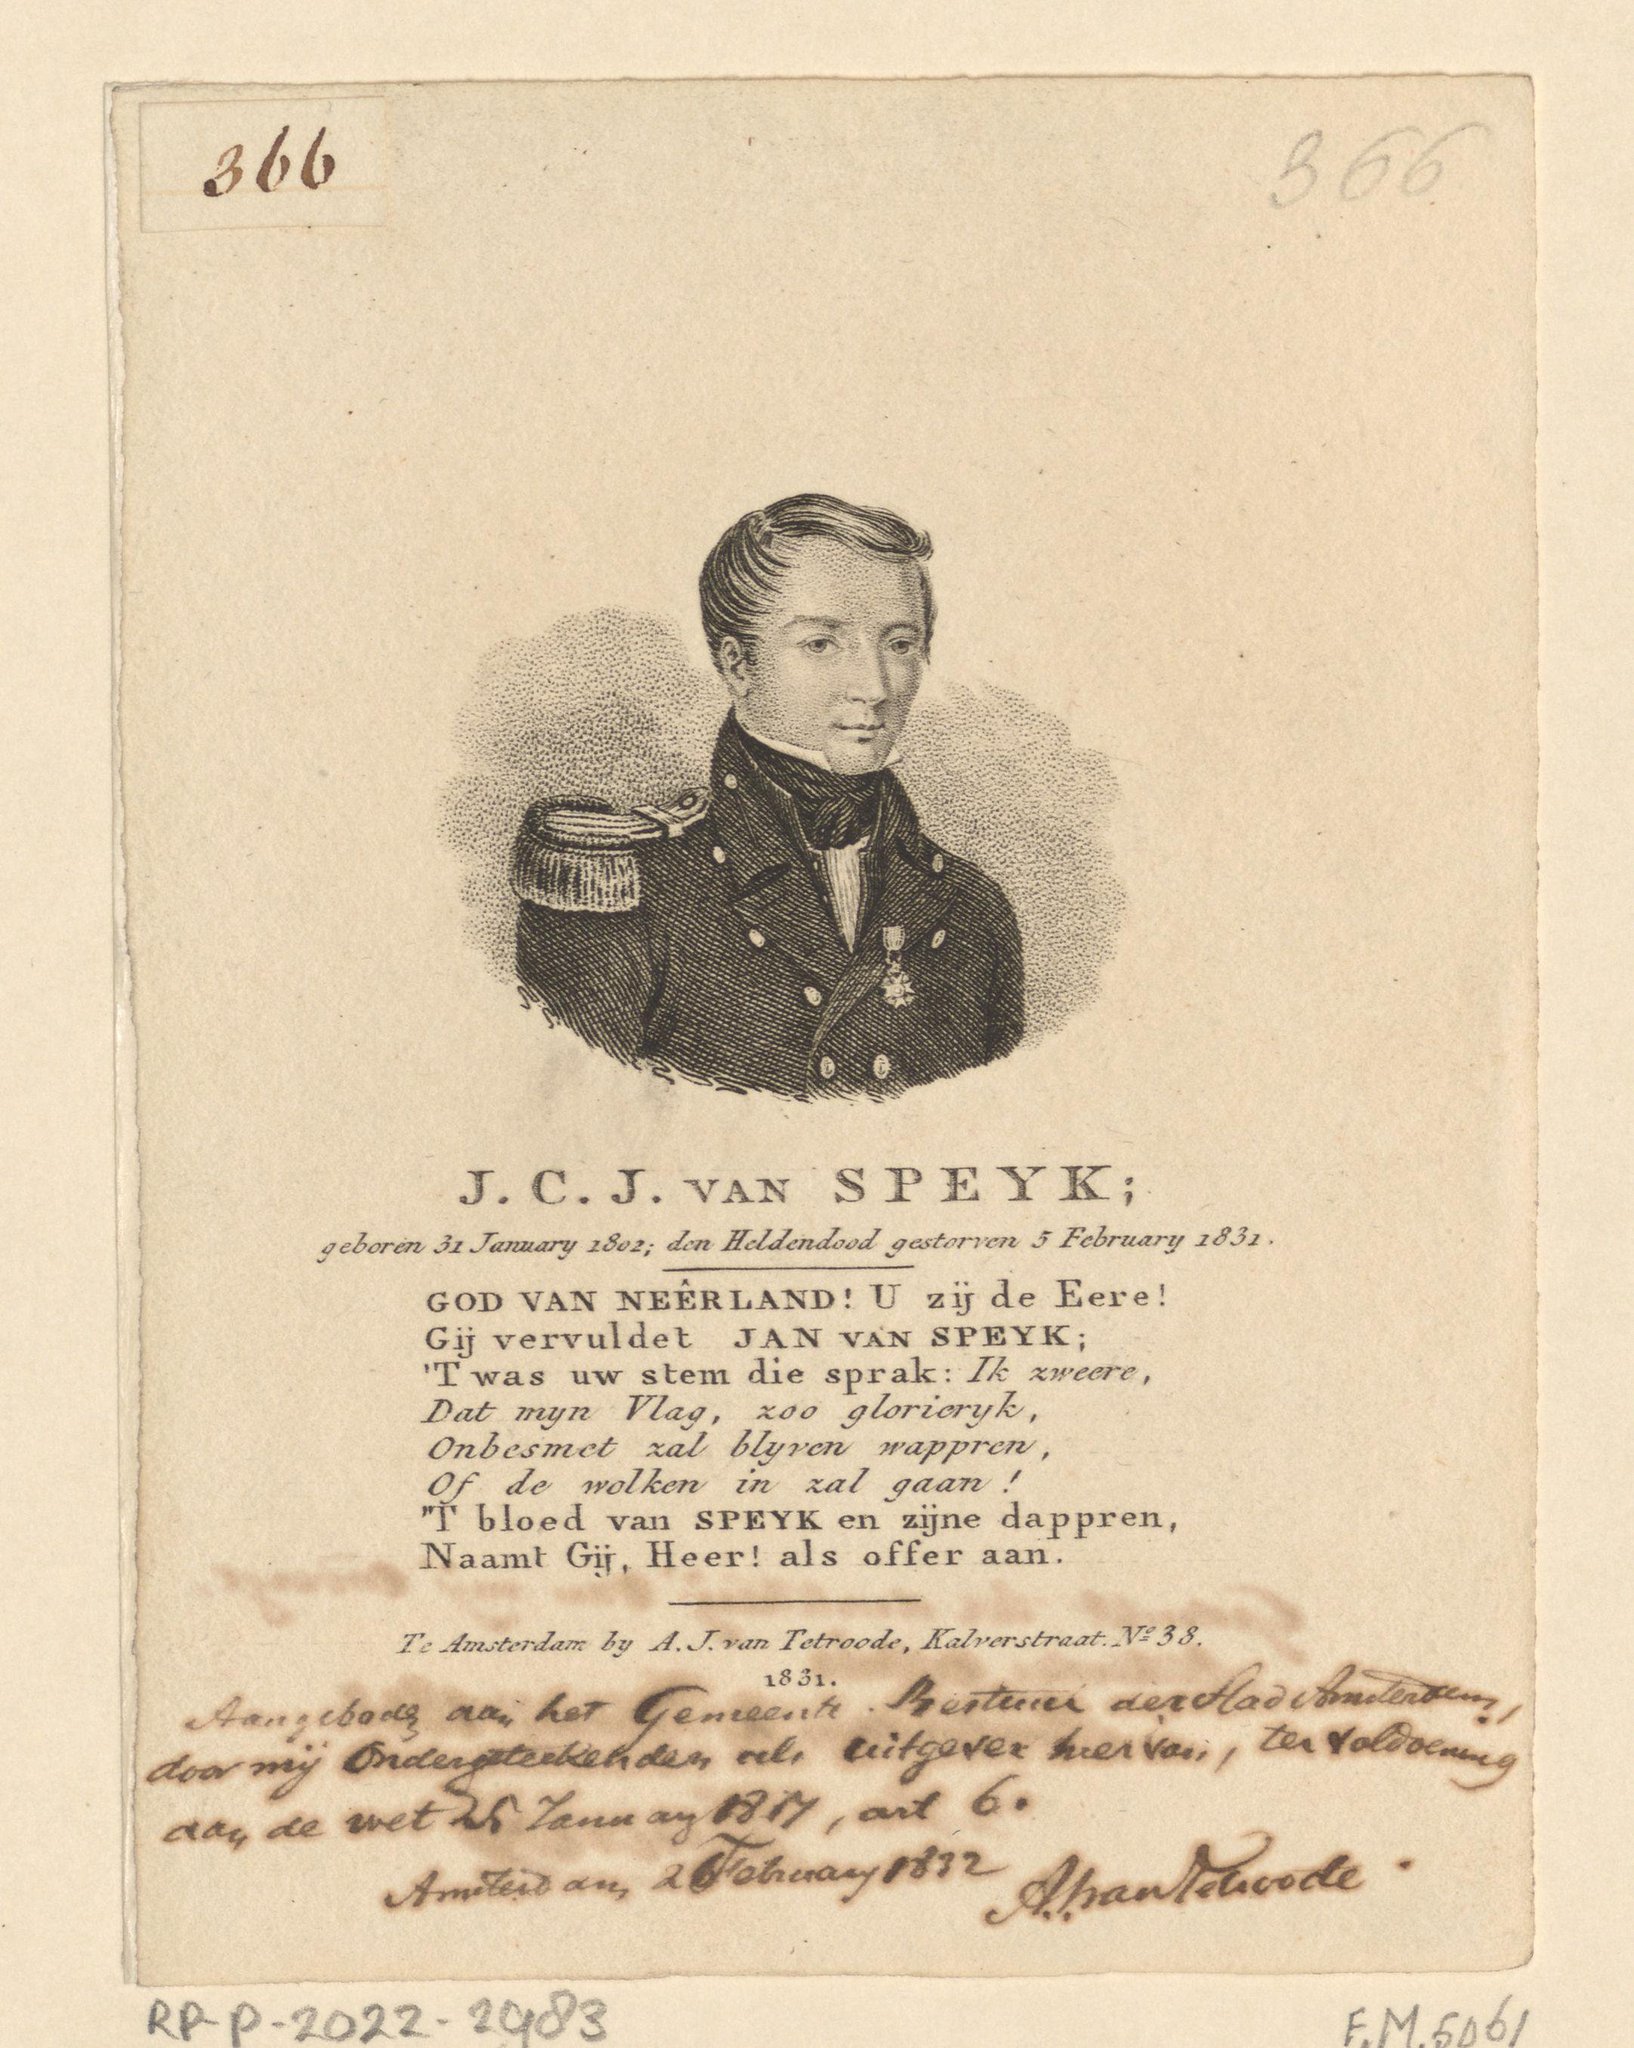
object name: print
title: Portret van Jan van Speyk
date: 1831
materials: paper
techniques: etching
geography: amsterdam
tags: amsterdam, antwerp, jan van speyk, historical persons, commander-in-chief, admiral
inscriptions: inscription: ‘Gedrukt ter drukkerij (...) 1832 / J. Don[...]’, : ‘Aangeboden aan het Gemeente Bestuur der Stad Amterdam, / door mij Ondergeteekenden als uitgever hiervan, ter voldoening / aan de wet 25 January 1817, art. 6 / Amsterdam, 26 February 1832 / A.J.vanTetroode.’, number: ‘366 / 366’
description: Met negenregelig onderschrift in het Nederlands.